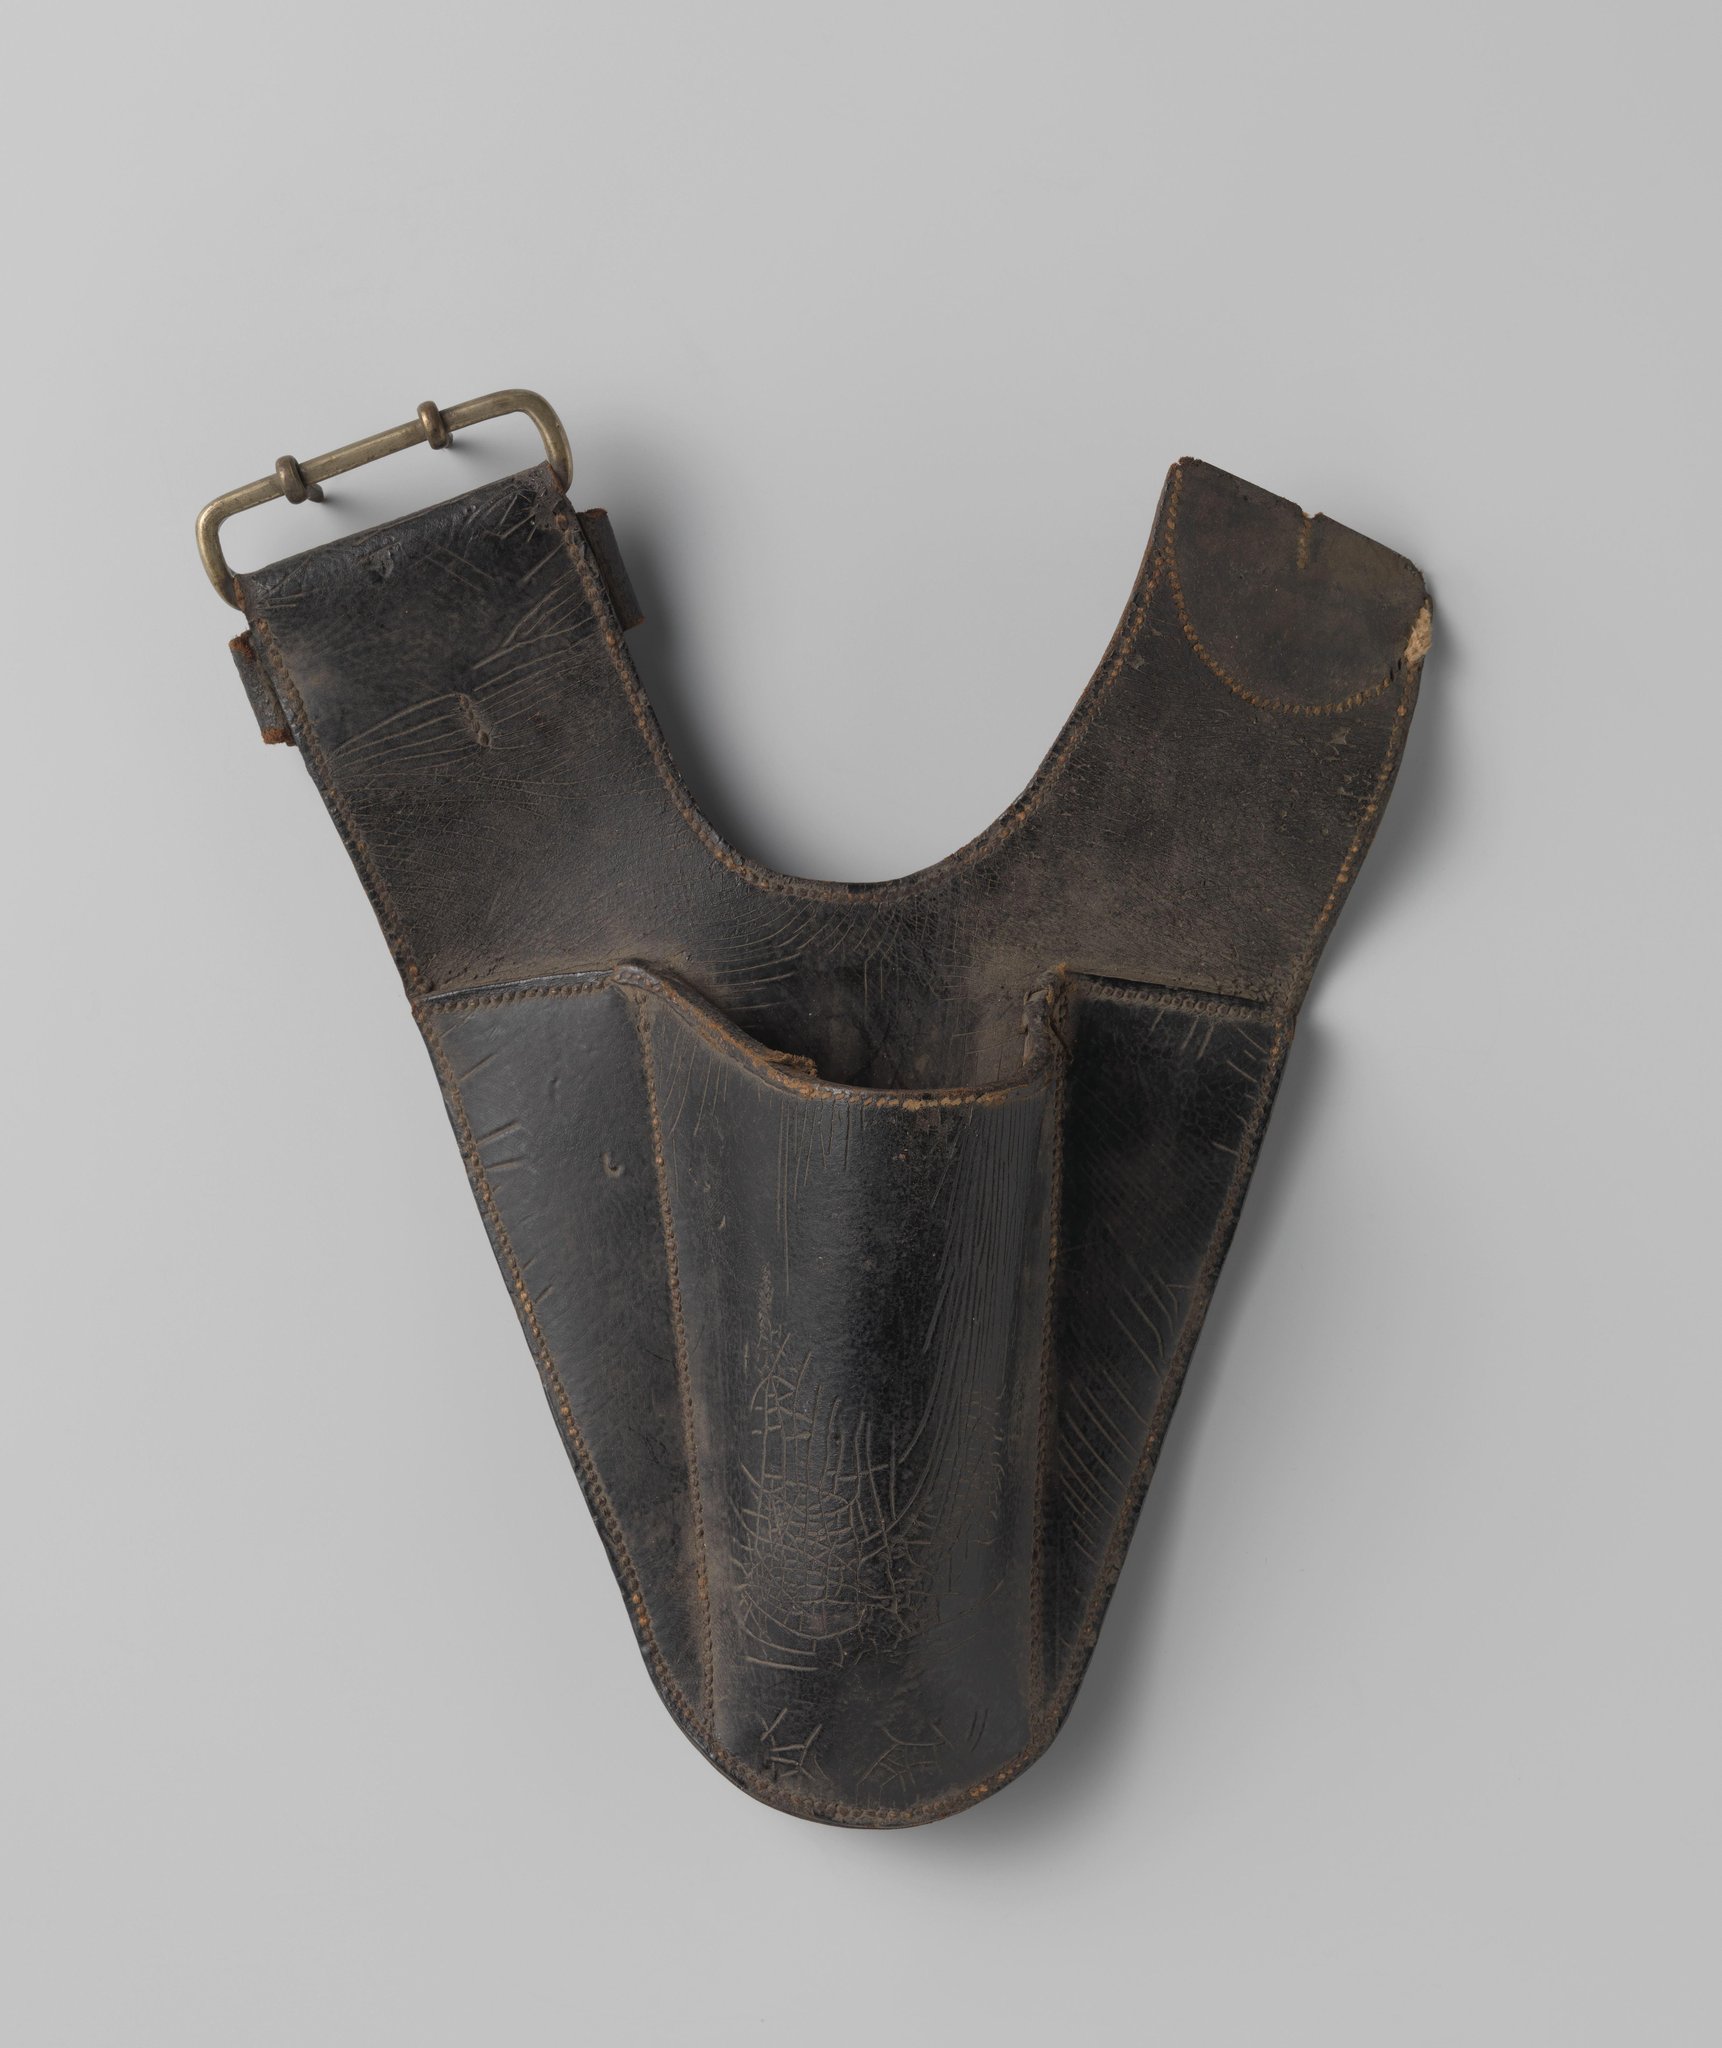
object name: bandolier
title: Draagband van leer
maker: Anonymous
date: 1400-1950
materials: copper, leather